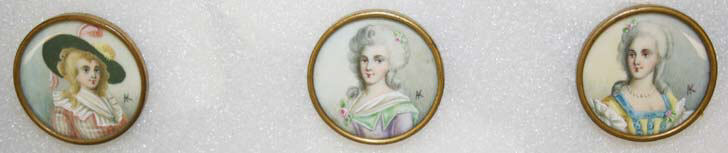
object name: button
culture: french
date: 1850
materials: glass, ivory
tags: portraits,women